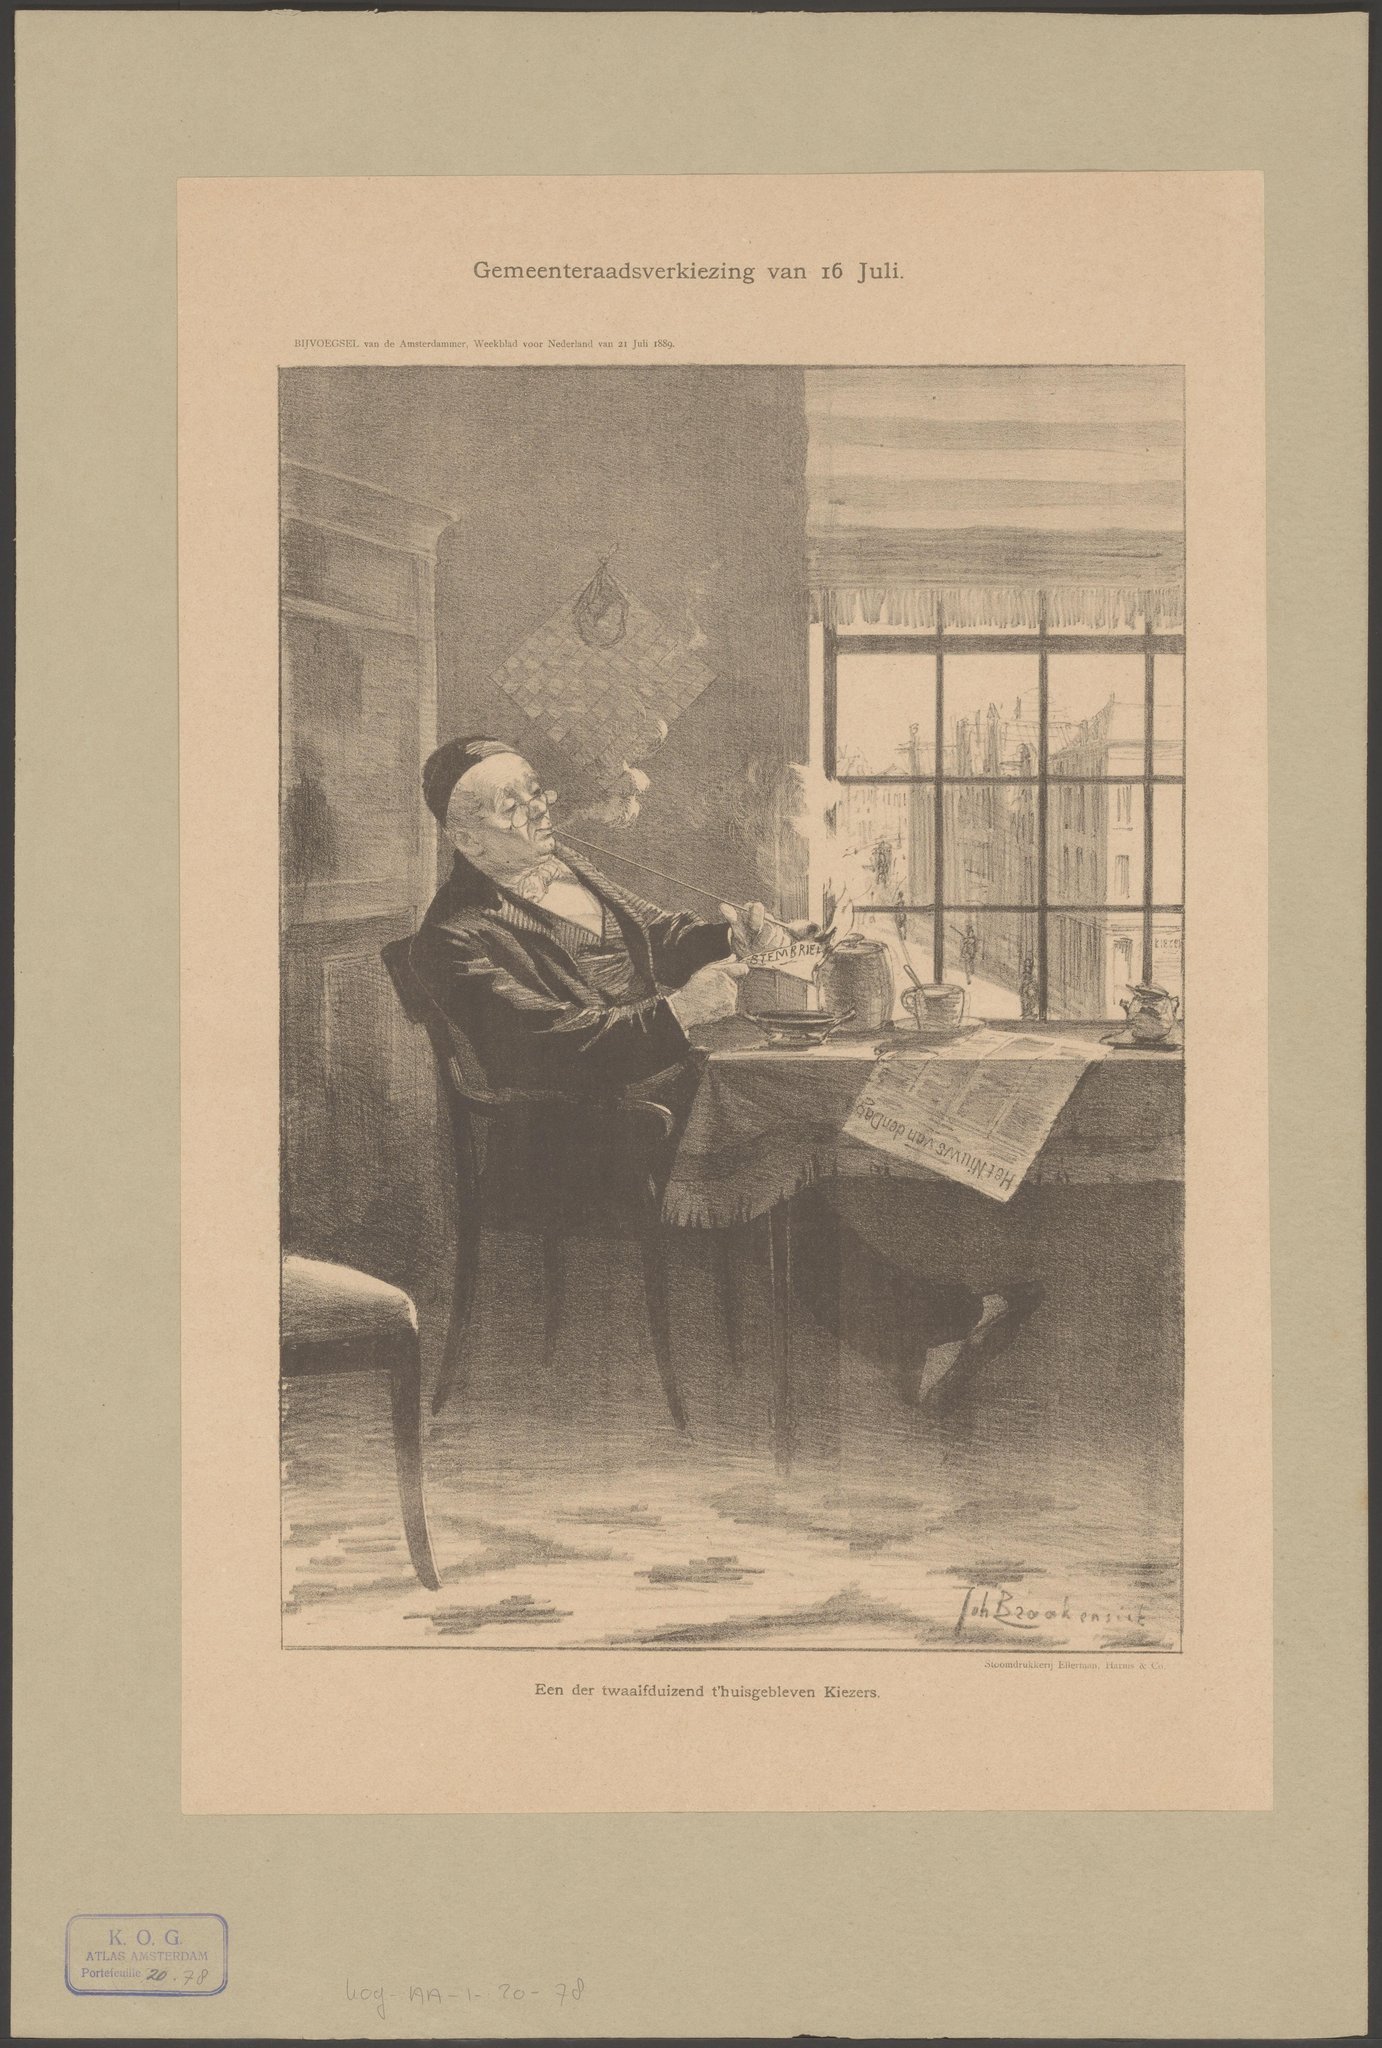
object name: cartoon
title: Gemeenteraadsverkiezing van 16 Juli / Een der twaalfduizend t'huisgebleven Kiezers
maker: johan braakensiek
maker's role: draughtsman, print maker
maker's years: 1858-1940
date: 1889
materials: paper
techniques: letterpress printing, lithograph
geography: amsterdam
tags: voting, election, voting ballot, pipe ~ tobacco, political caricatures and satires, amsterdam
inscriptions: collector's mark: Lugt 1641b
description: Een man zit aan een tafel en steekt zijn pijp aan met zijn stembiljet. Onderwerpsrubriek binnen de Atlas Amsterdam: Verkiezingen Gemeenteraad.